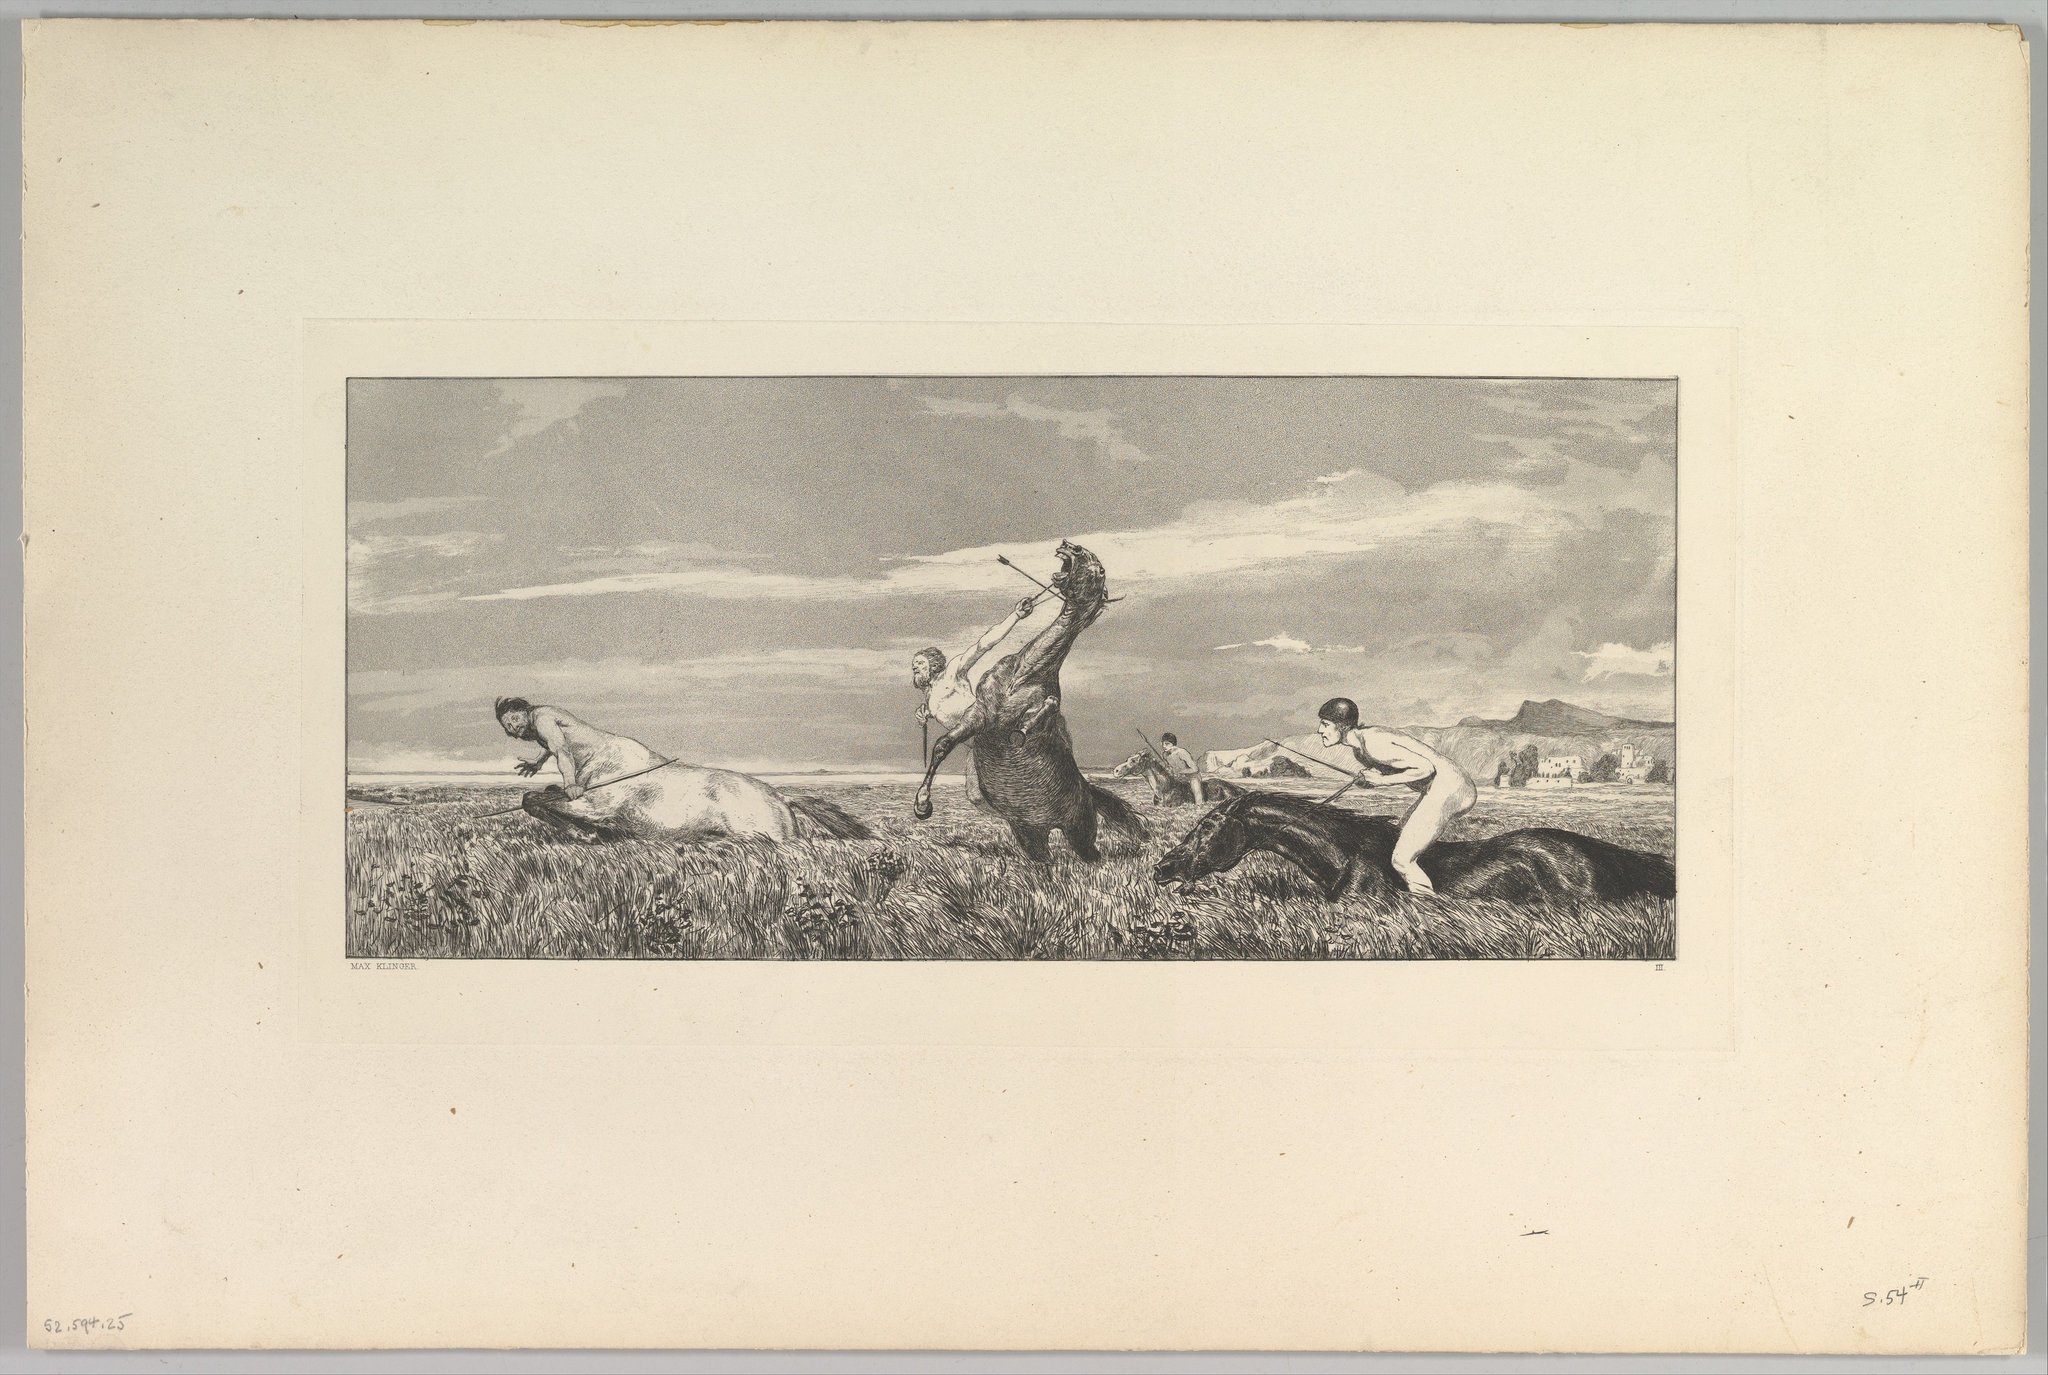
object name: print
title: Verfolgter Centaur, from the series Intermezzi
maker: max klinger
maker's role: artist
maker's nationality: german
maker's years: 1857-1920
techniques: aquatint, printmaking, etching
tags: men,centaurs,horses